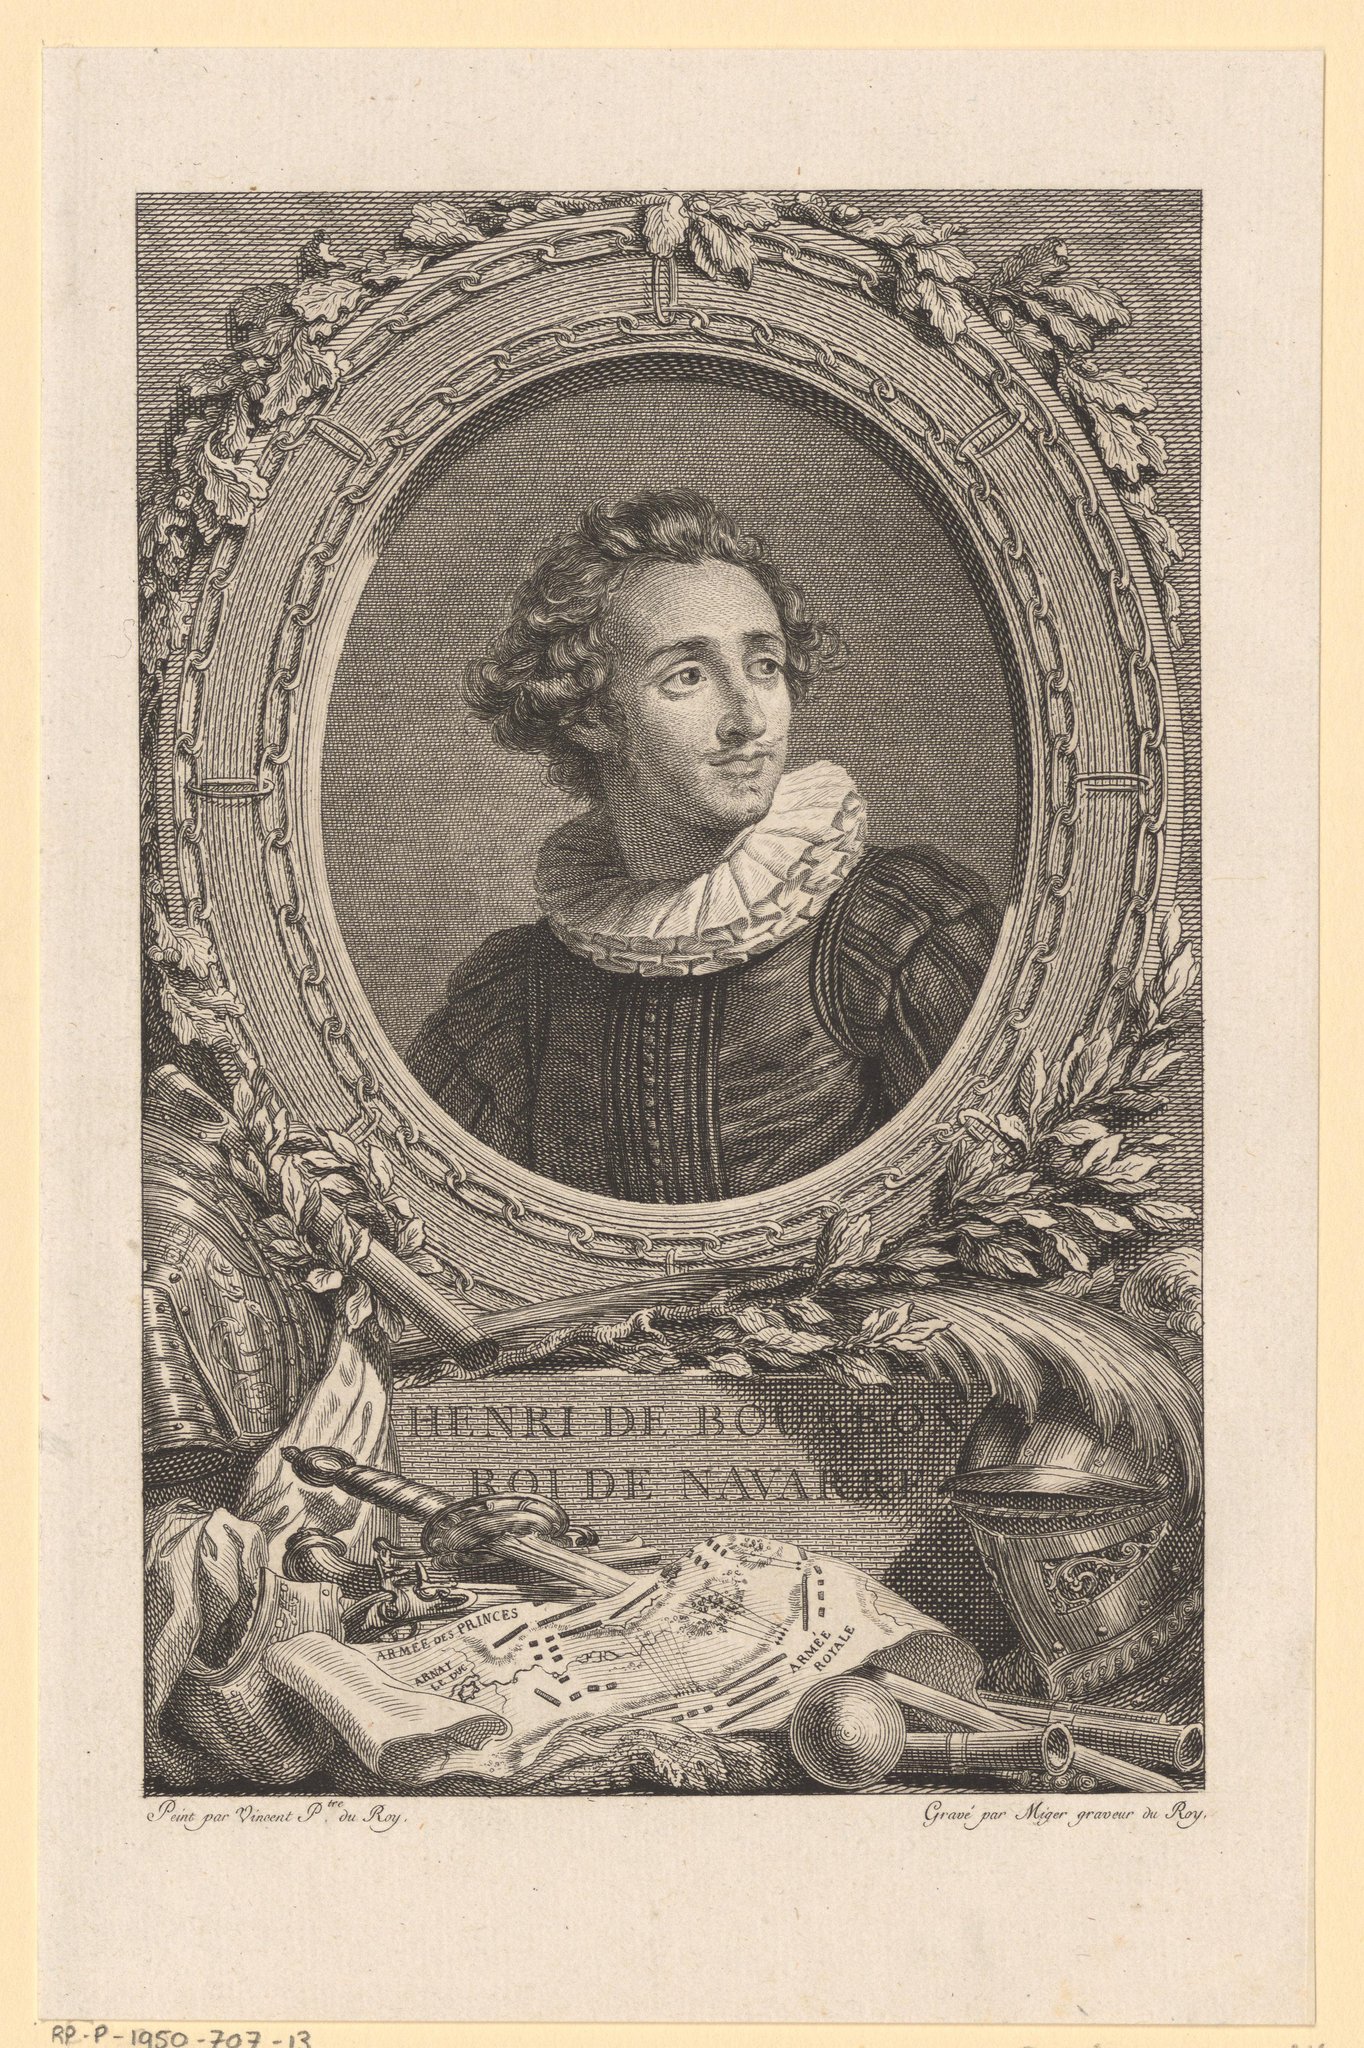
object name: print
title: Portret van Hendrik IV, koning van Frankrijk en Navarra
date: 1786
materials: paper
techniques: engraving, etching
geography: paris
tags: paris, hendrik iv (koning van frankrijk en navarra), historical persons, king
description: Prent uit: Desormeaux, Joseph-Louis-Ripault. Histoire de la Maison de Bourbon. Parijs: Imprimerie Royale, 1786, dl. 4.